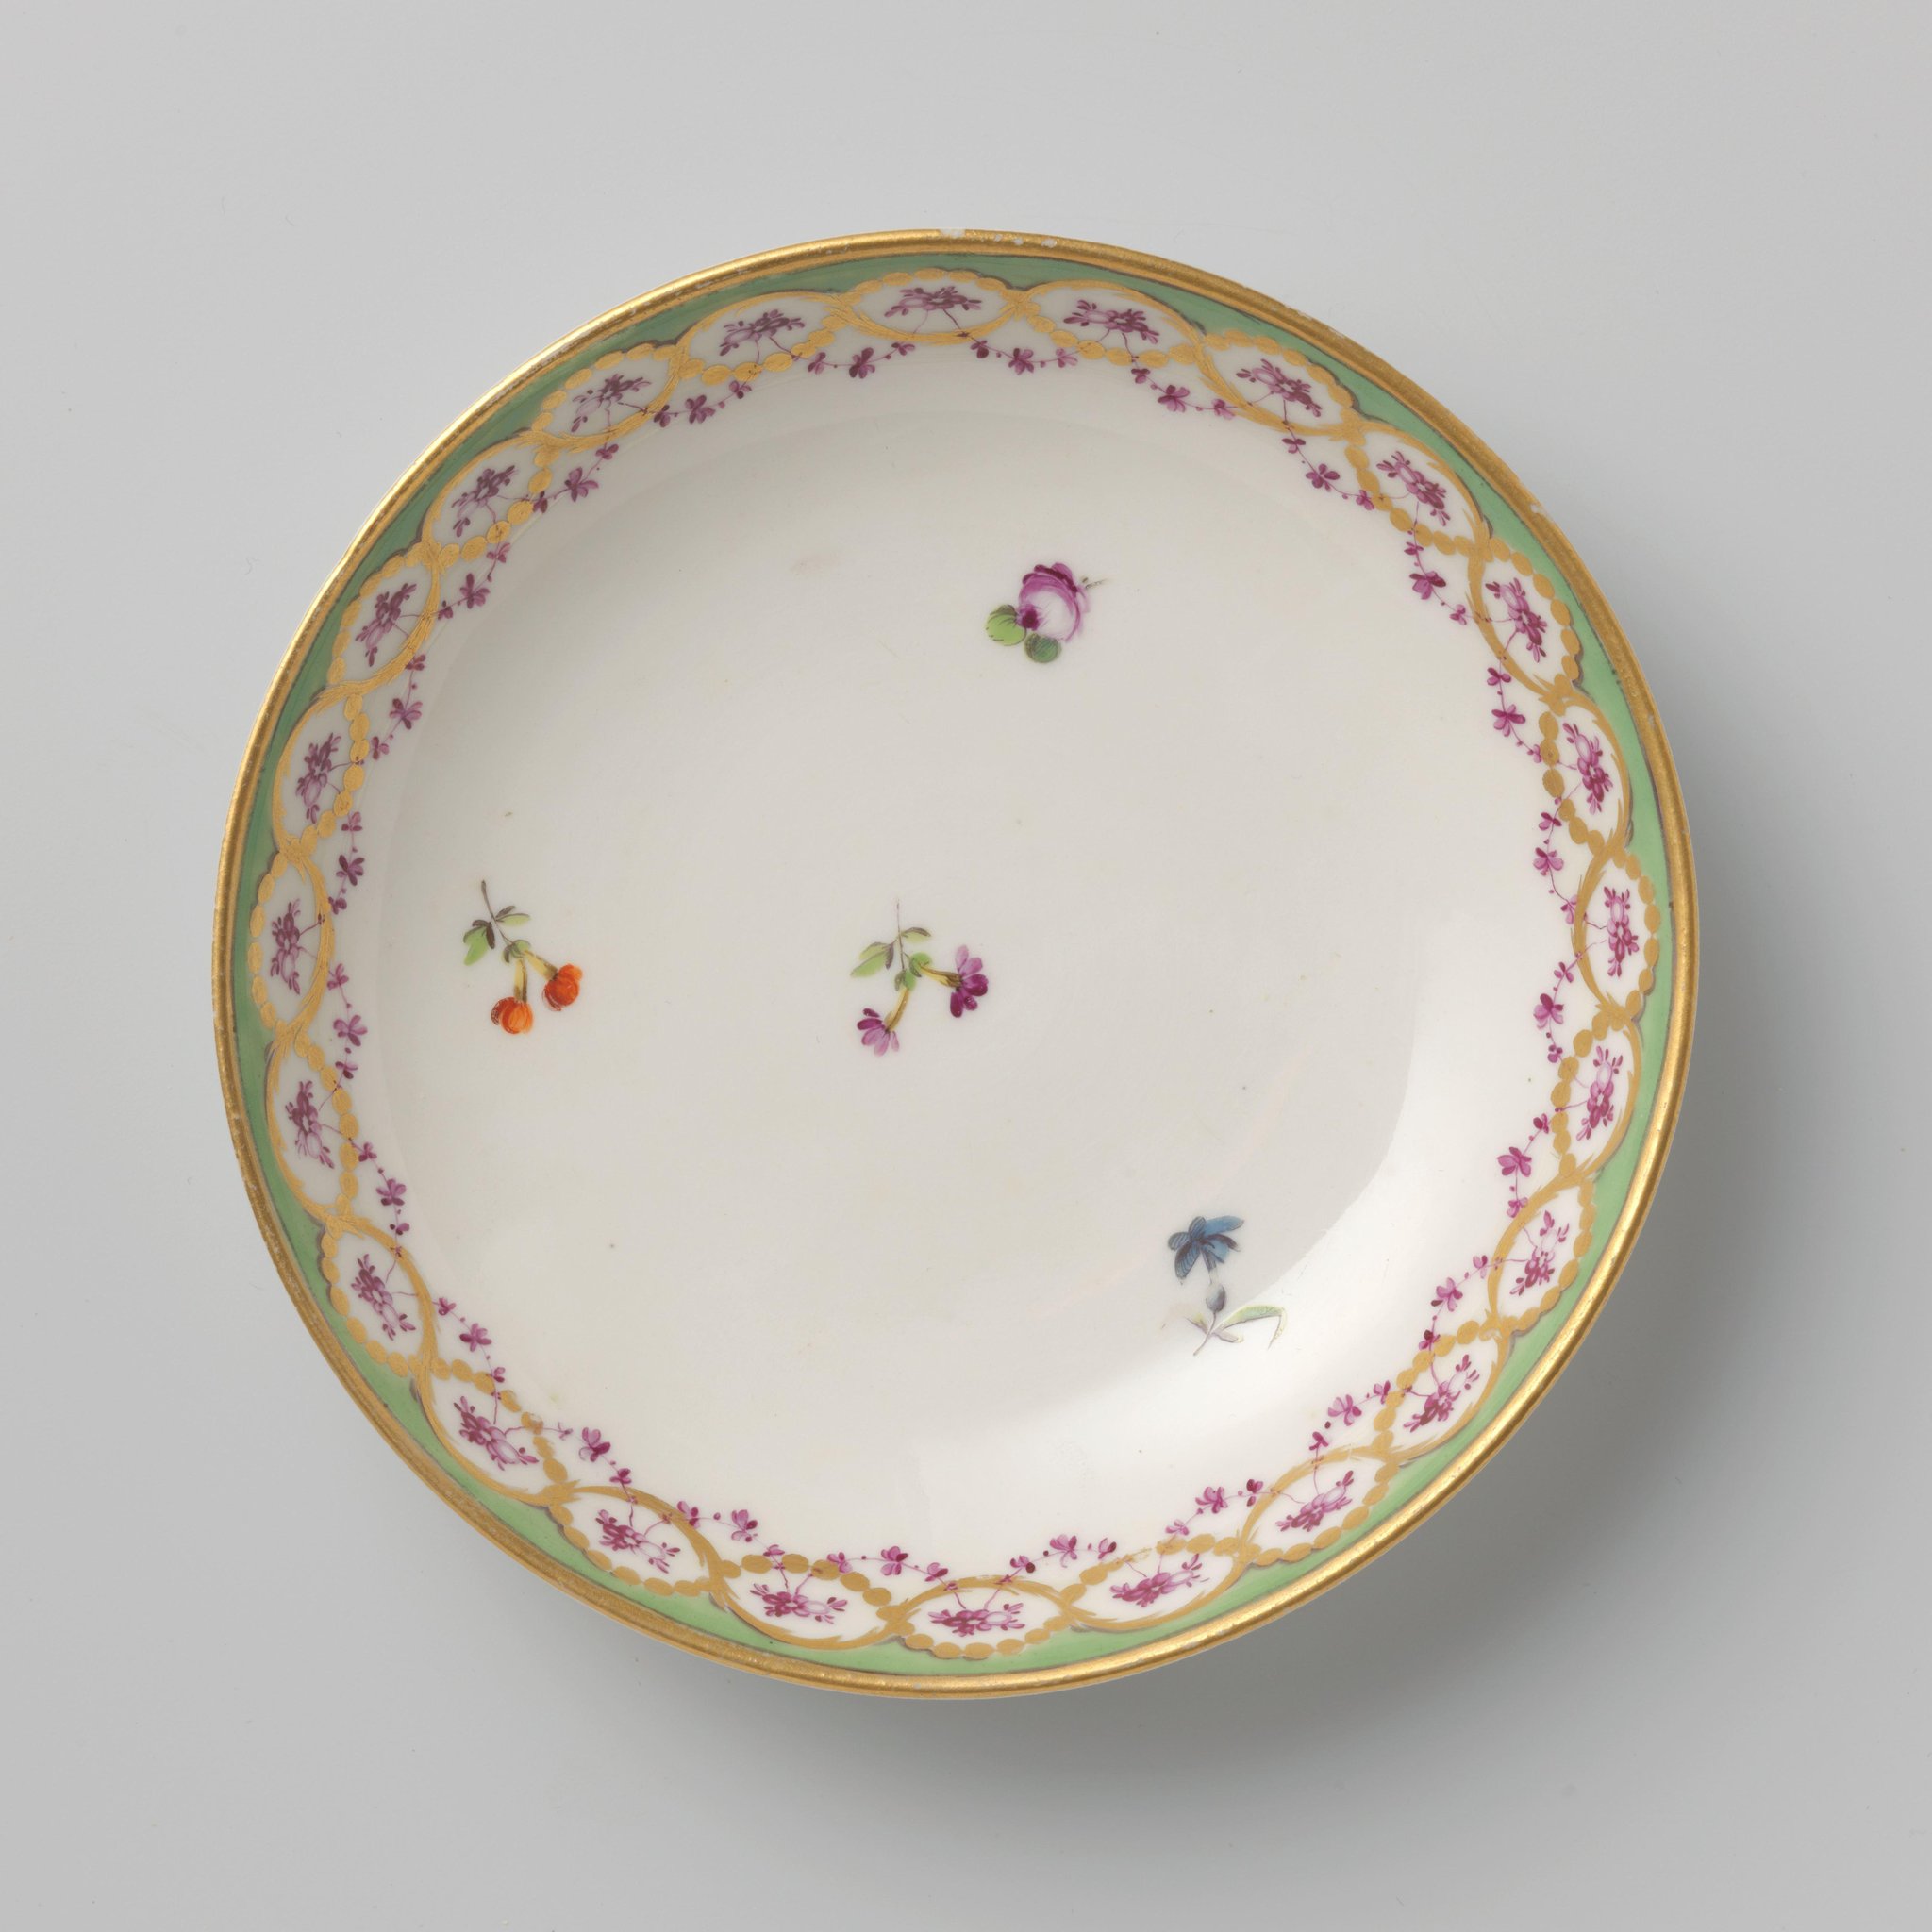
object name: tea service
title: Schotel van theeservies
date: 1784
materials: porcelain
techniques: painted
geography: loosdrecht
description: Schotel van theeservies. De versiering bestaat uit strooibloemen op het plat en langs de rand een geornamenteerde band. Gemerkt Amstel.